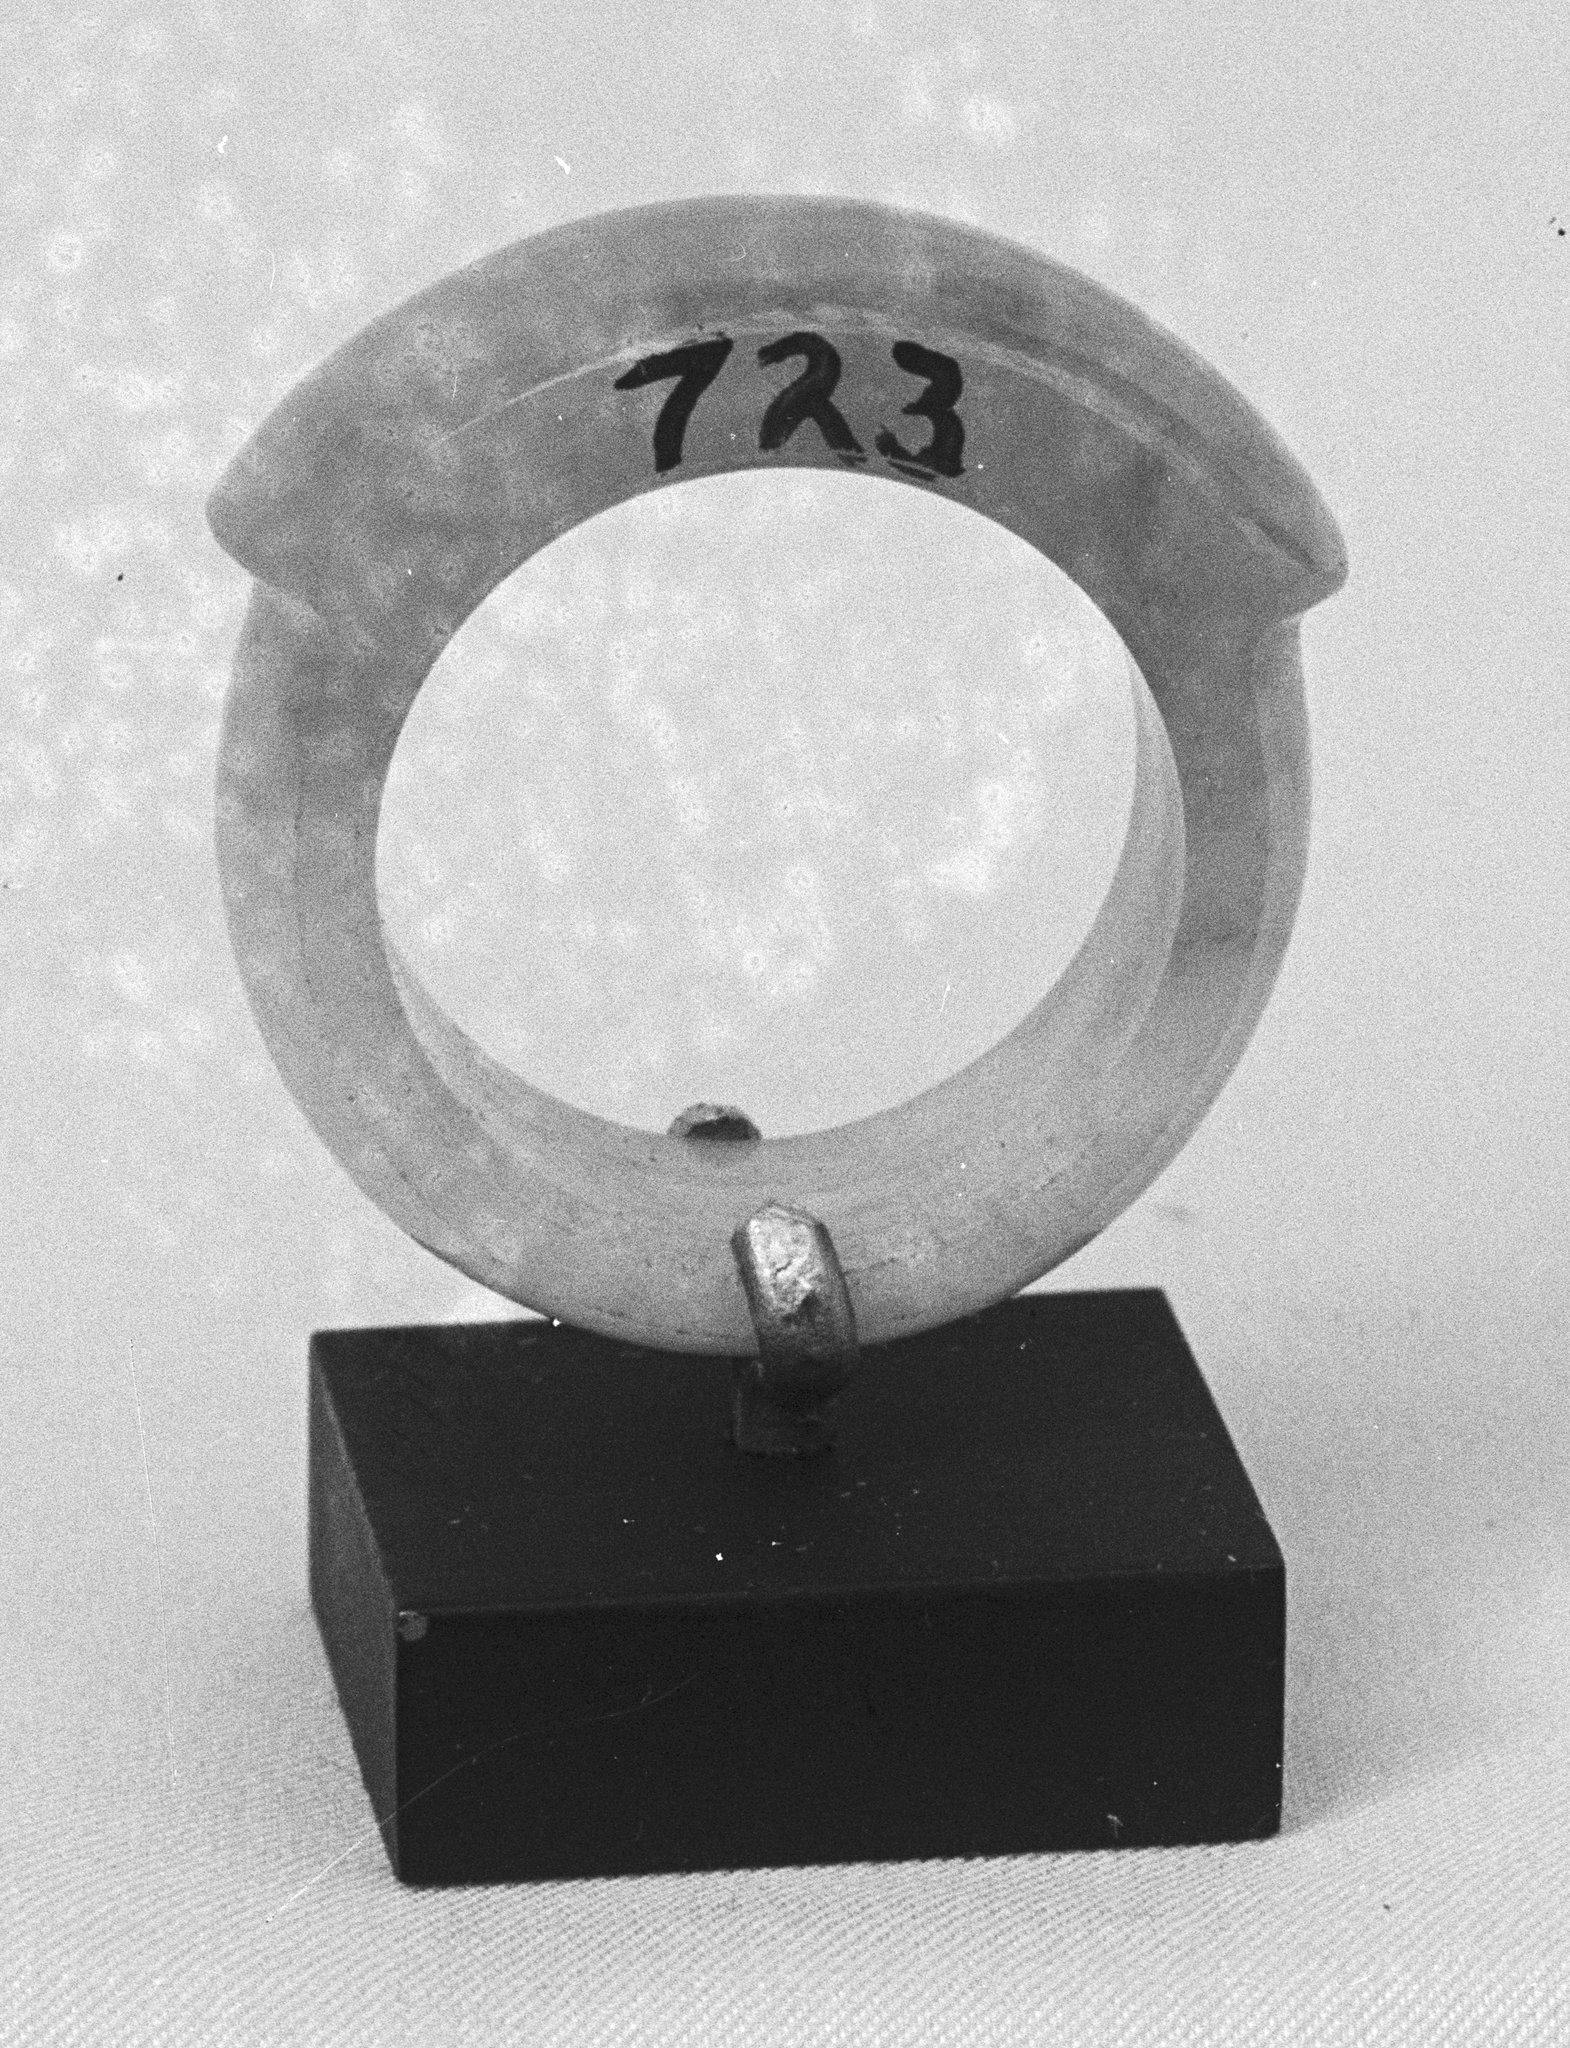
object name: ring, finger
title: Finger ring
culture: chinese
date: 1796-1875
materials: gemstone, jade